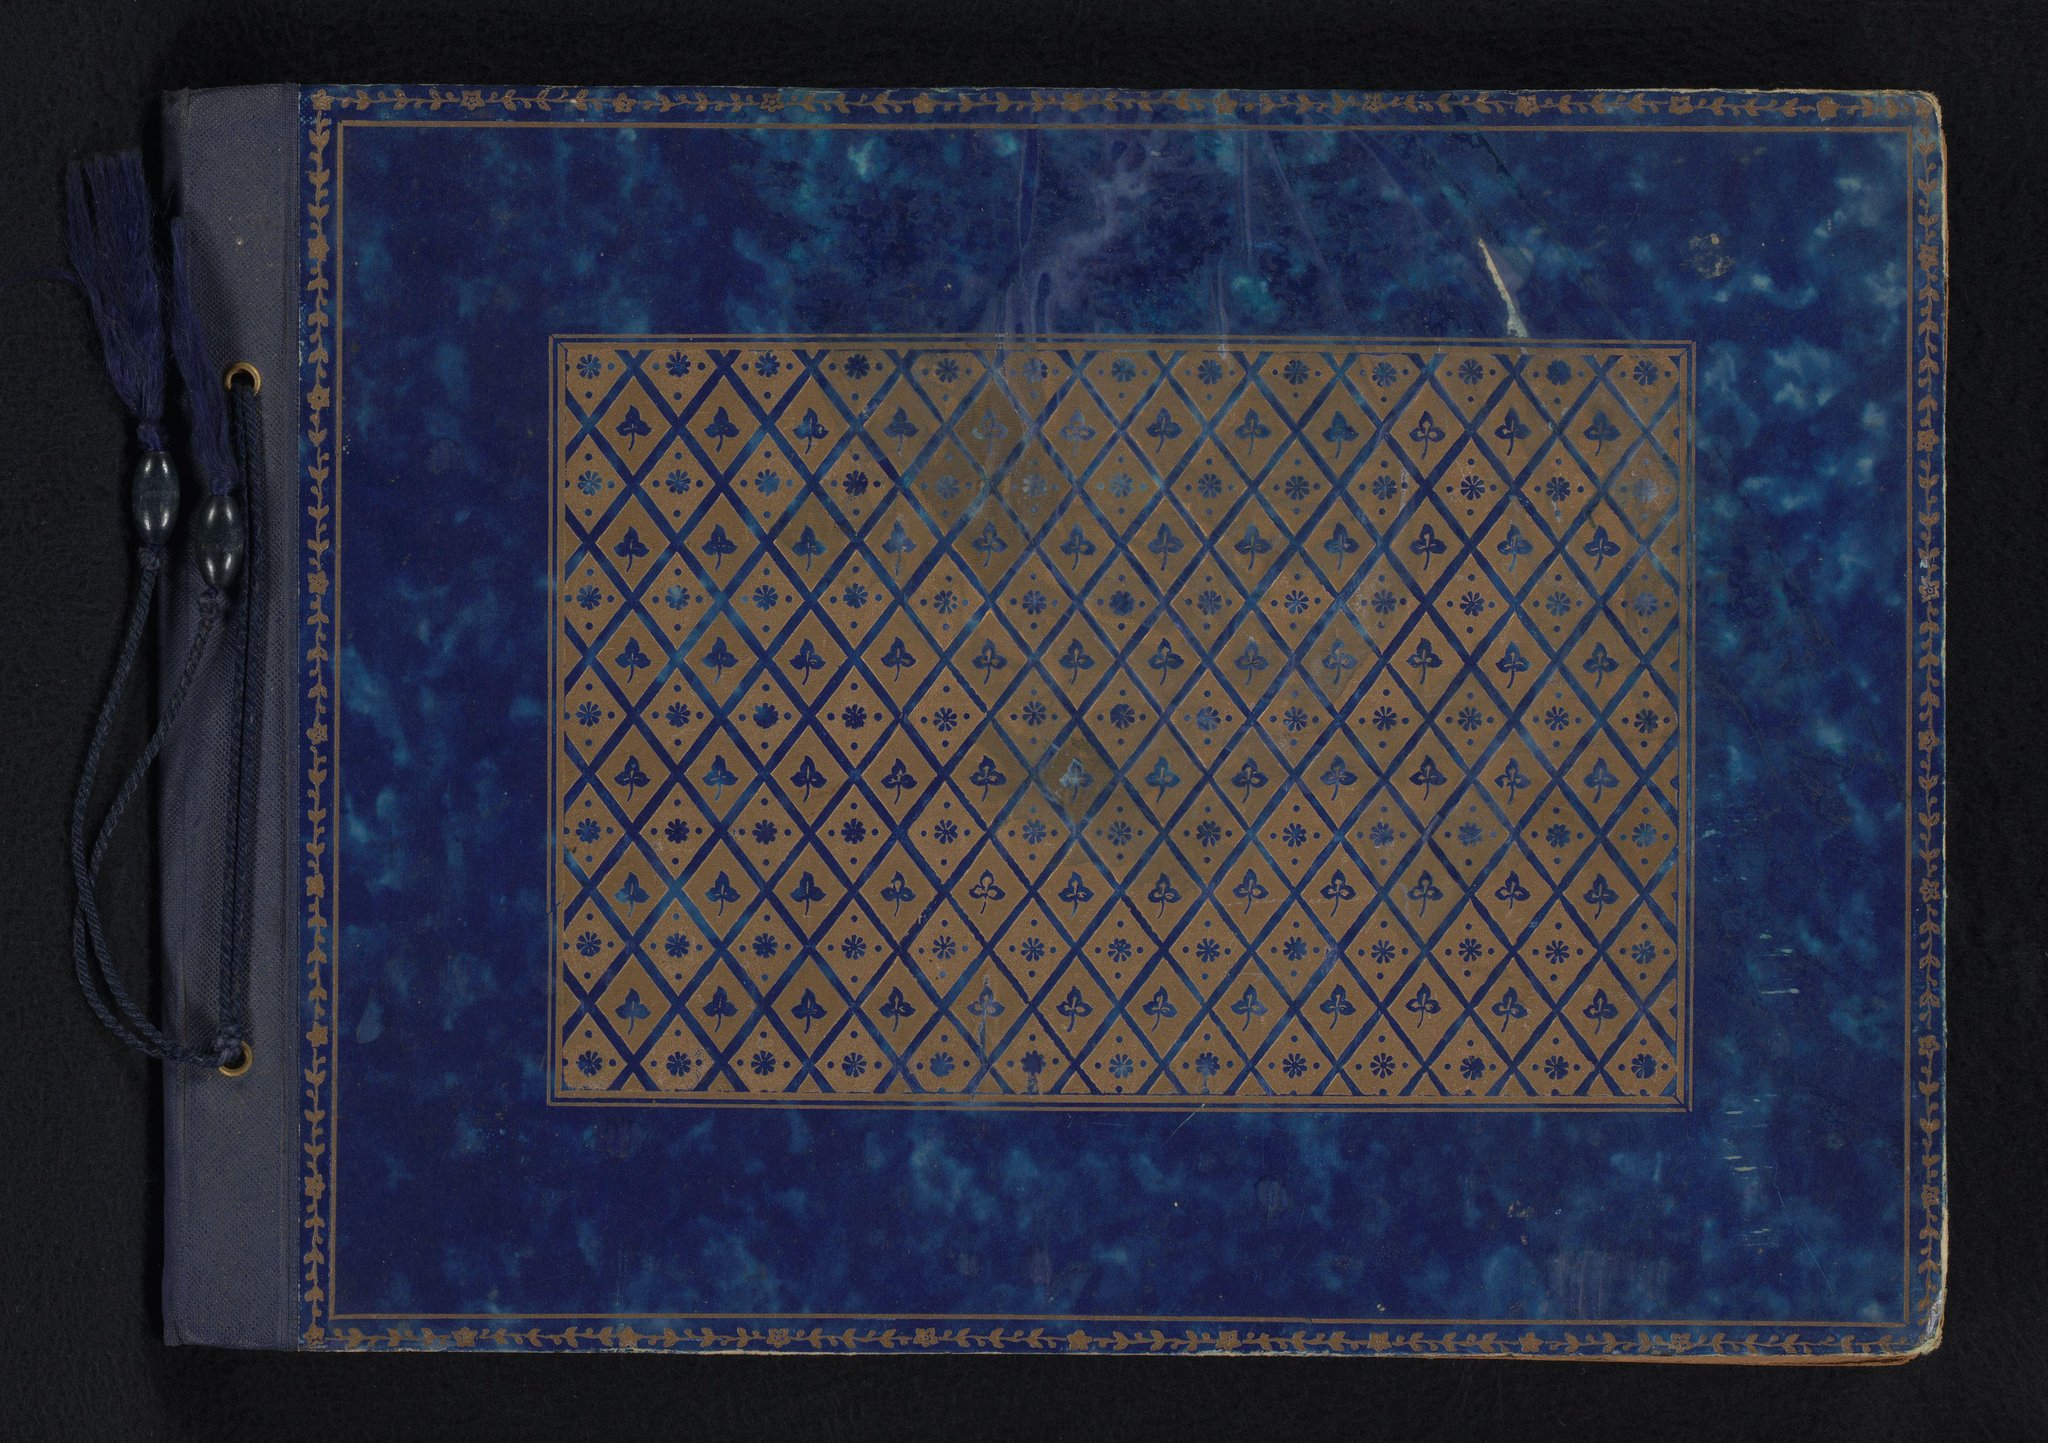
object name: photograph album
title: Familiealbum van een Chinees-Indische familie in Weltevreden, ca. 1935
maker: Anonymous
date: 1935-1936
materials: paper, photographic support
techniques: gelatin silver print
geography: china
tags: china, indonesia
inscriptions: inscription: ‘Thung Siang Bok / G. Lecha 60 / Weltevreden’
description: Fotoalbum met een blauw papieren omslag, bedrukt met goud. Het album bevat 24 bladen van bruin karton, met een blauw koord in omslag gebonden. Het album bevat in totaal 131 zwart-wit foto's van met name een Chinees-Indische familie. Op het voorblad staat een naam en adres geschreven, mogelijk de eigenaar of samensteller van het album: Thung Liang Bok, [kampong] G[ang] Zecha 60, Weltevreden. Met meedere foto's van een excursie naar Pengalengan door leden van de Chung-Hsiok van Batavia en Bandoeng. De Chung-Hsiok was een bond van jonge Chinezen in Nederlands-Indië.